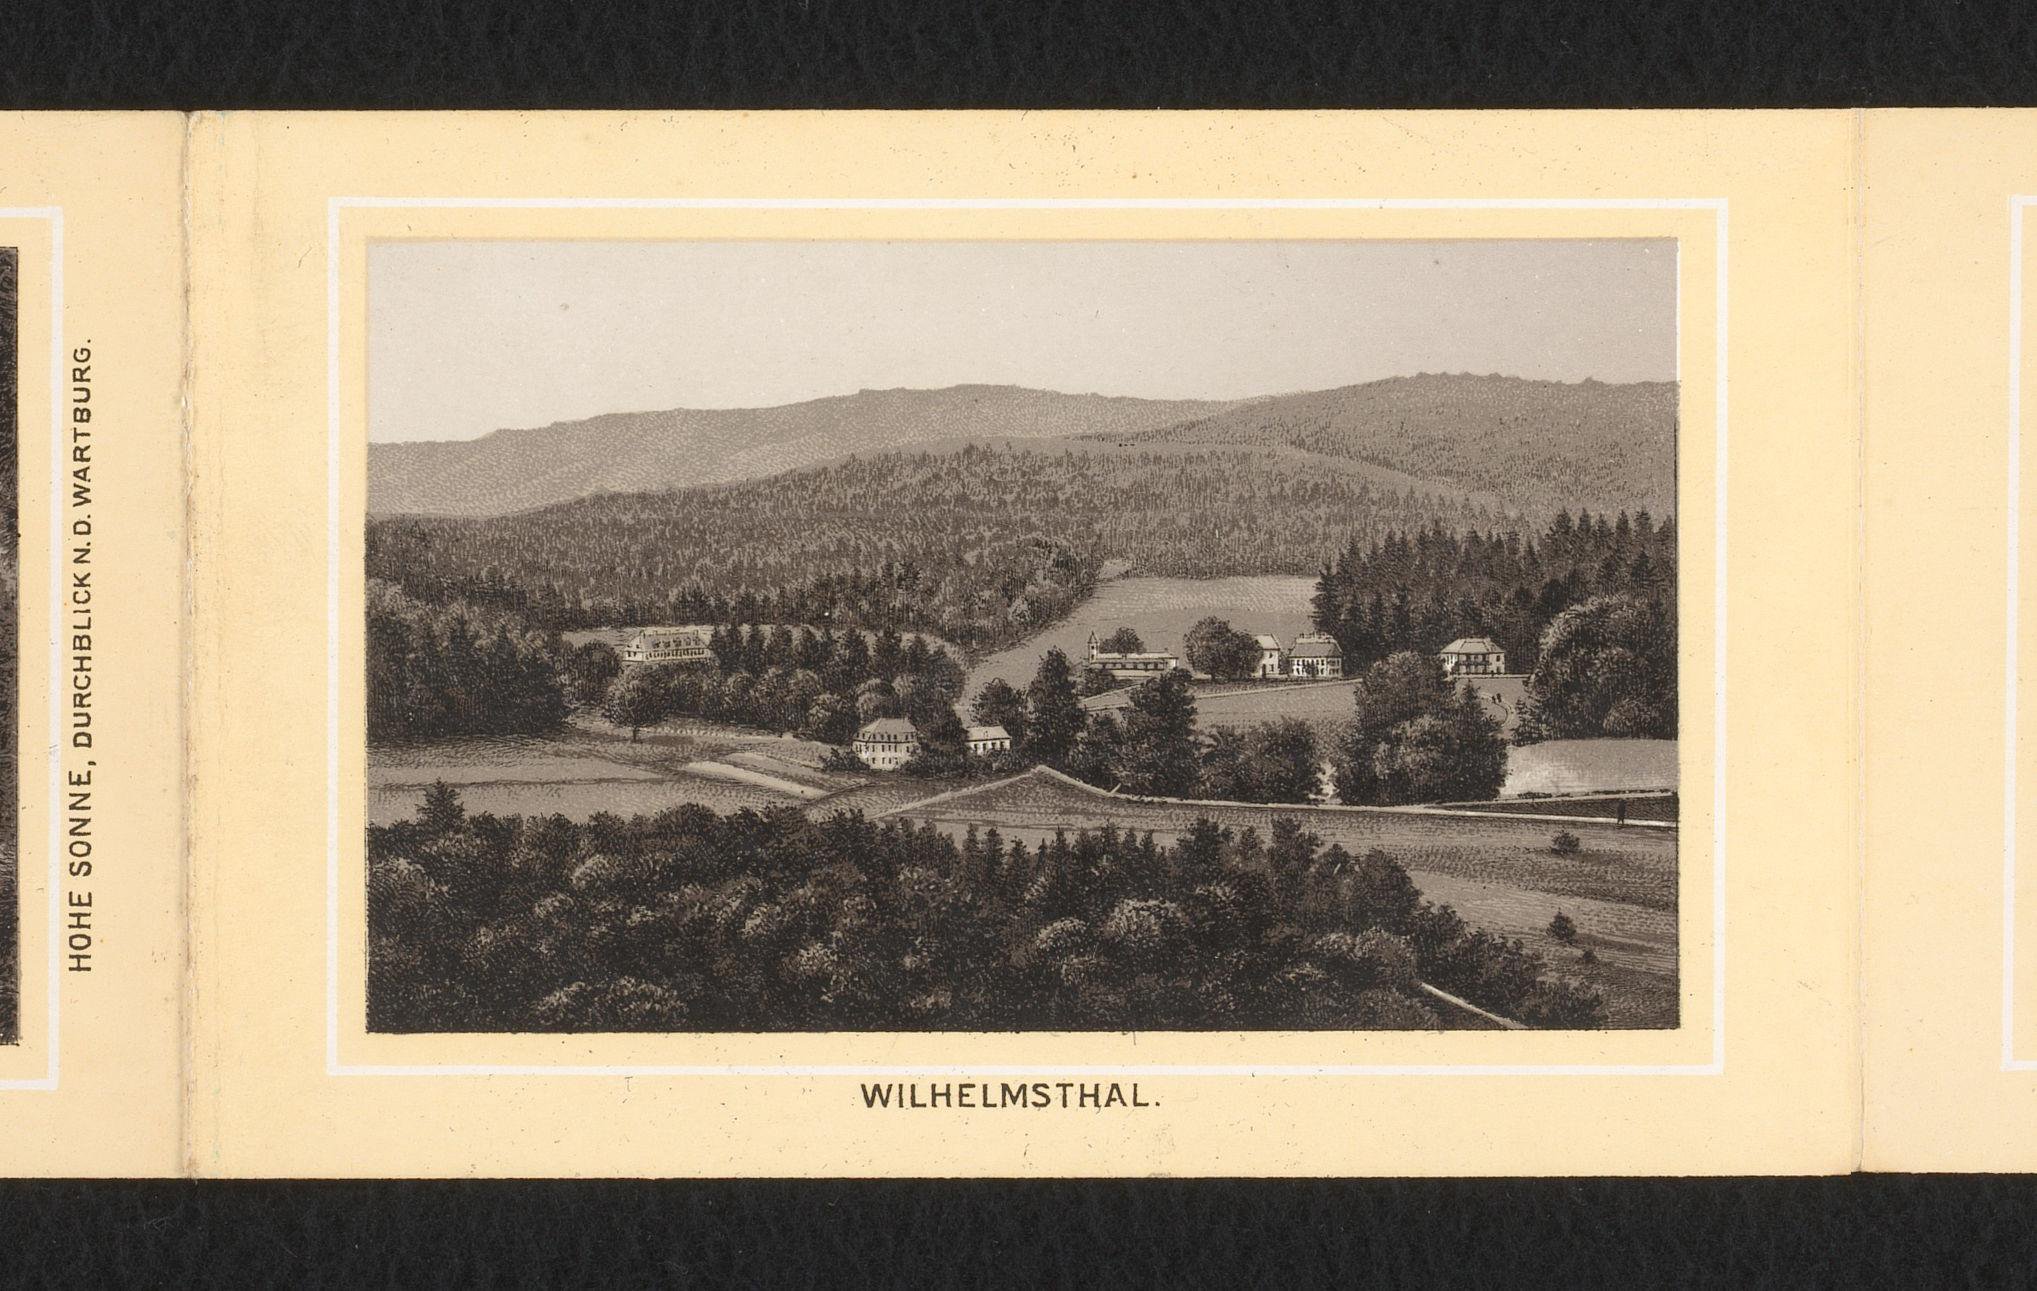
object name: ansichtkaart, prentbriefkaart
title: Wilhelmsthal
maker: louis glaser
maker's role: printer, publisher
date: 1874-1900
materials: cardboard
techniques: photolithography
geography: leipzig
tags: city-view, and landscape with man-made constructions, mountains